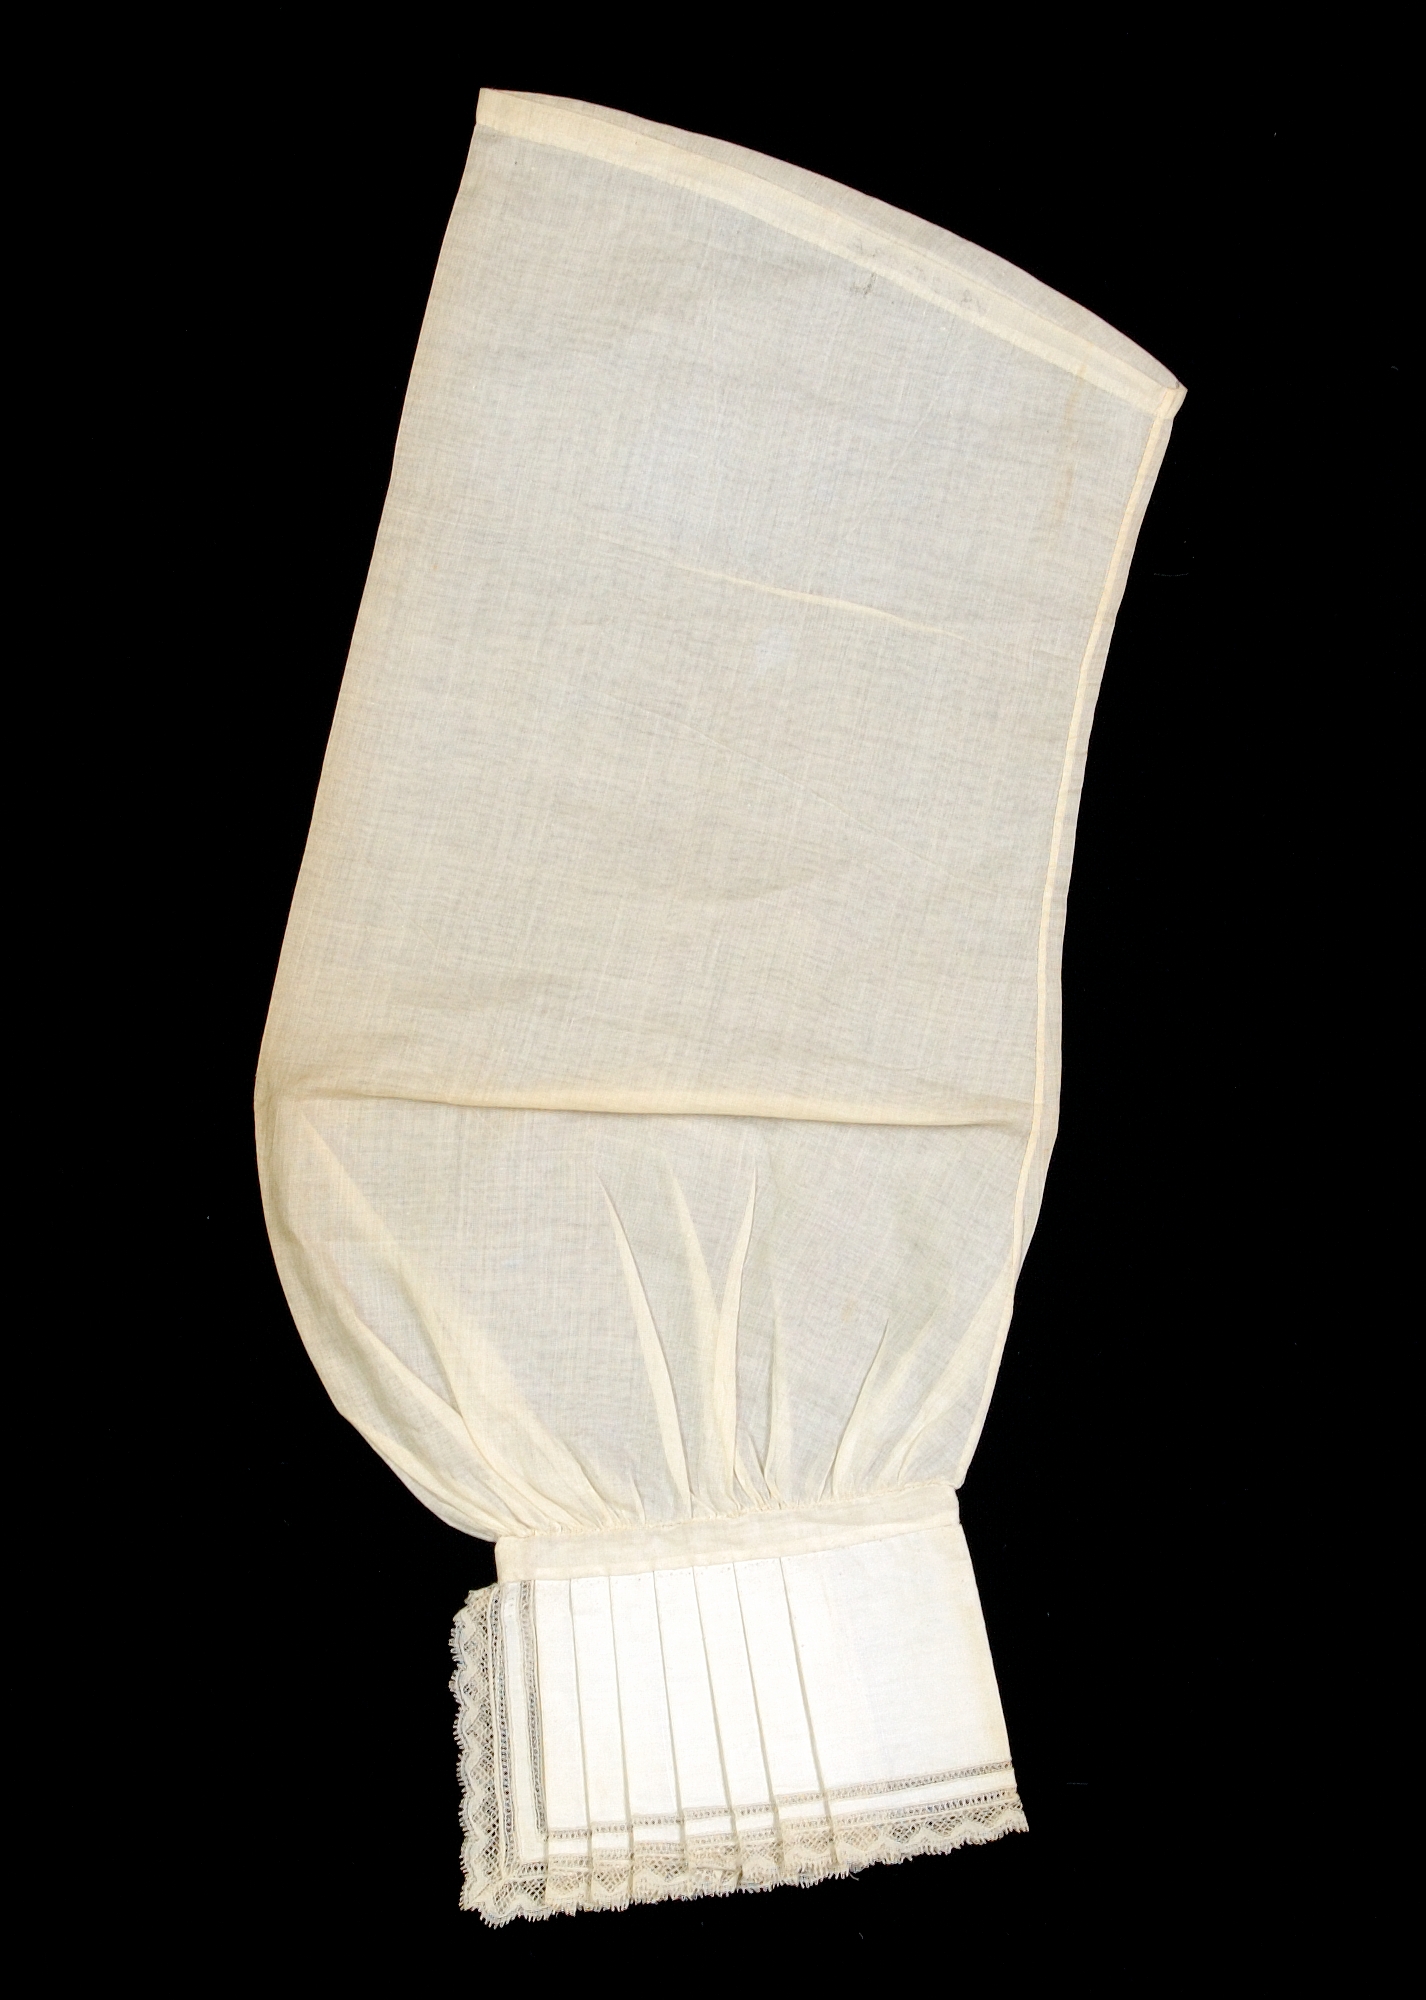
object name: undersleeves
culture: american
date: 1870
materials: cotton